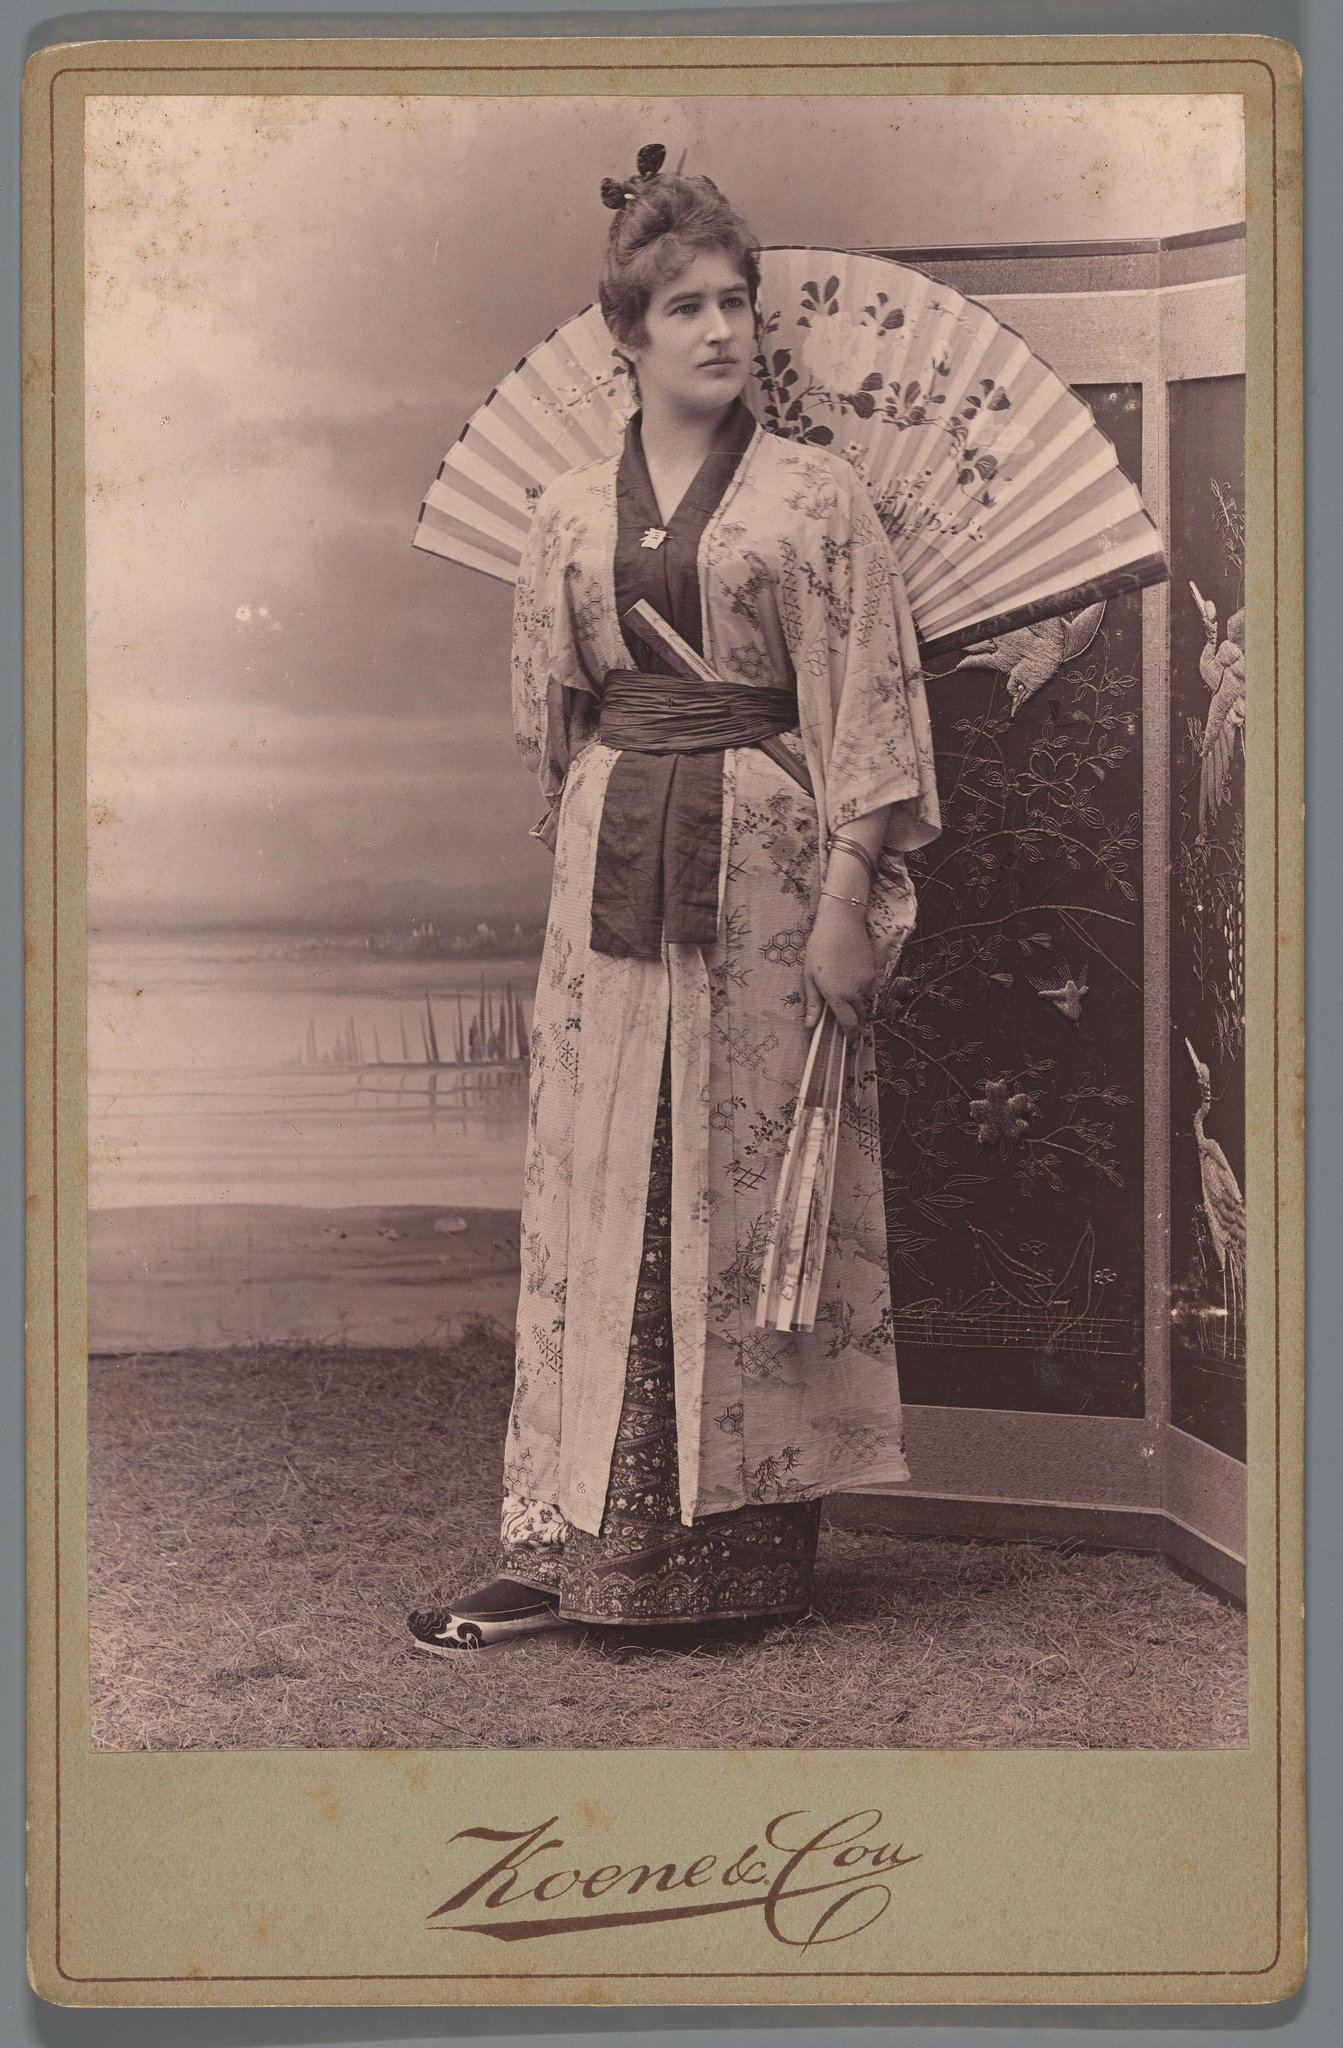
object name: cabinet photograph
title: Studioportret van Delle Dupuis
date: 1890-1920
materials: cardboard, photographic support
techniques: albumen print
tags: delle dupuis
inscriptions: name: ‘Delle Dupuis’, name: ‘Koene & Co’, name: ‘BATAVIA / Koene & Co / AMSTERDAM / ALKMAAR’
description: Staande vrouw voor een kamerscherm met waaier achter haar hoofd en een waaier in haar linkerhand.